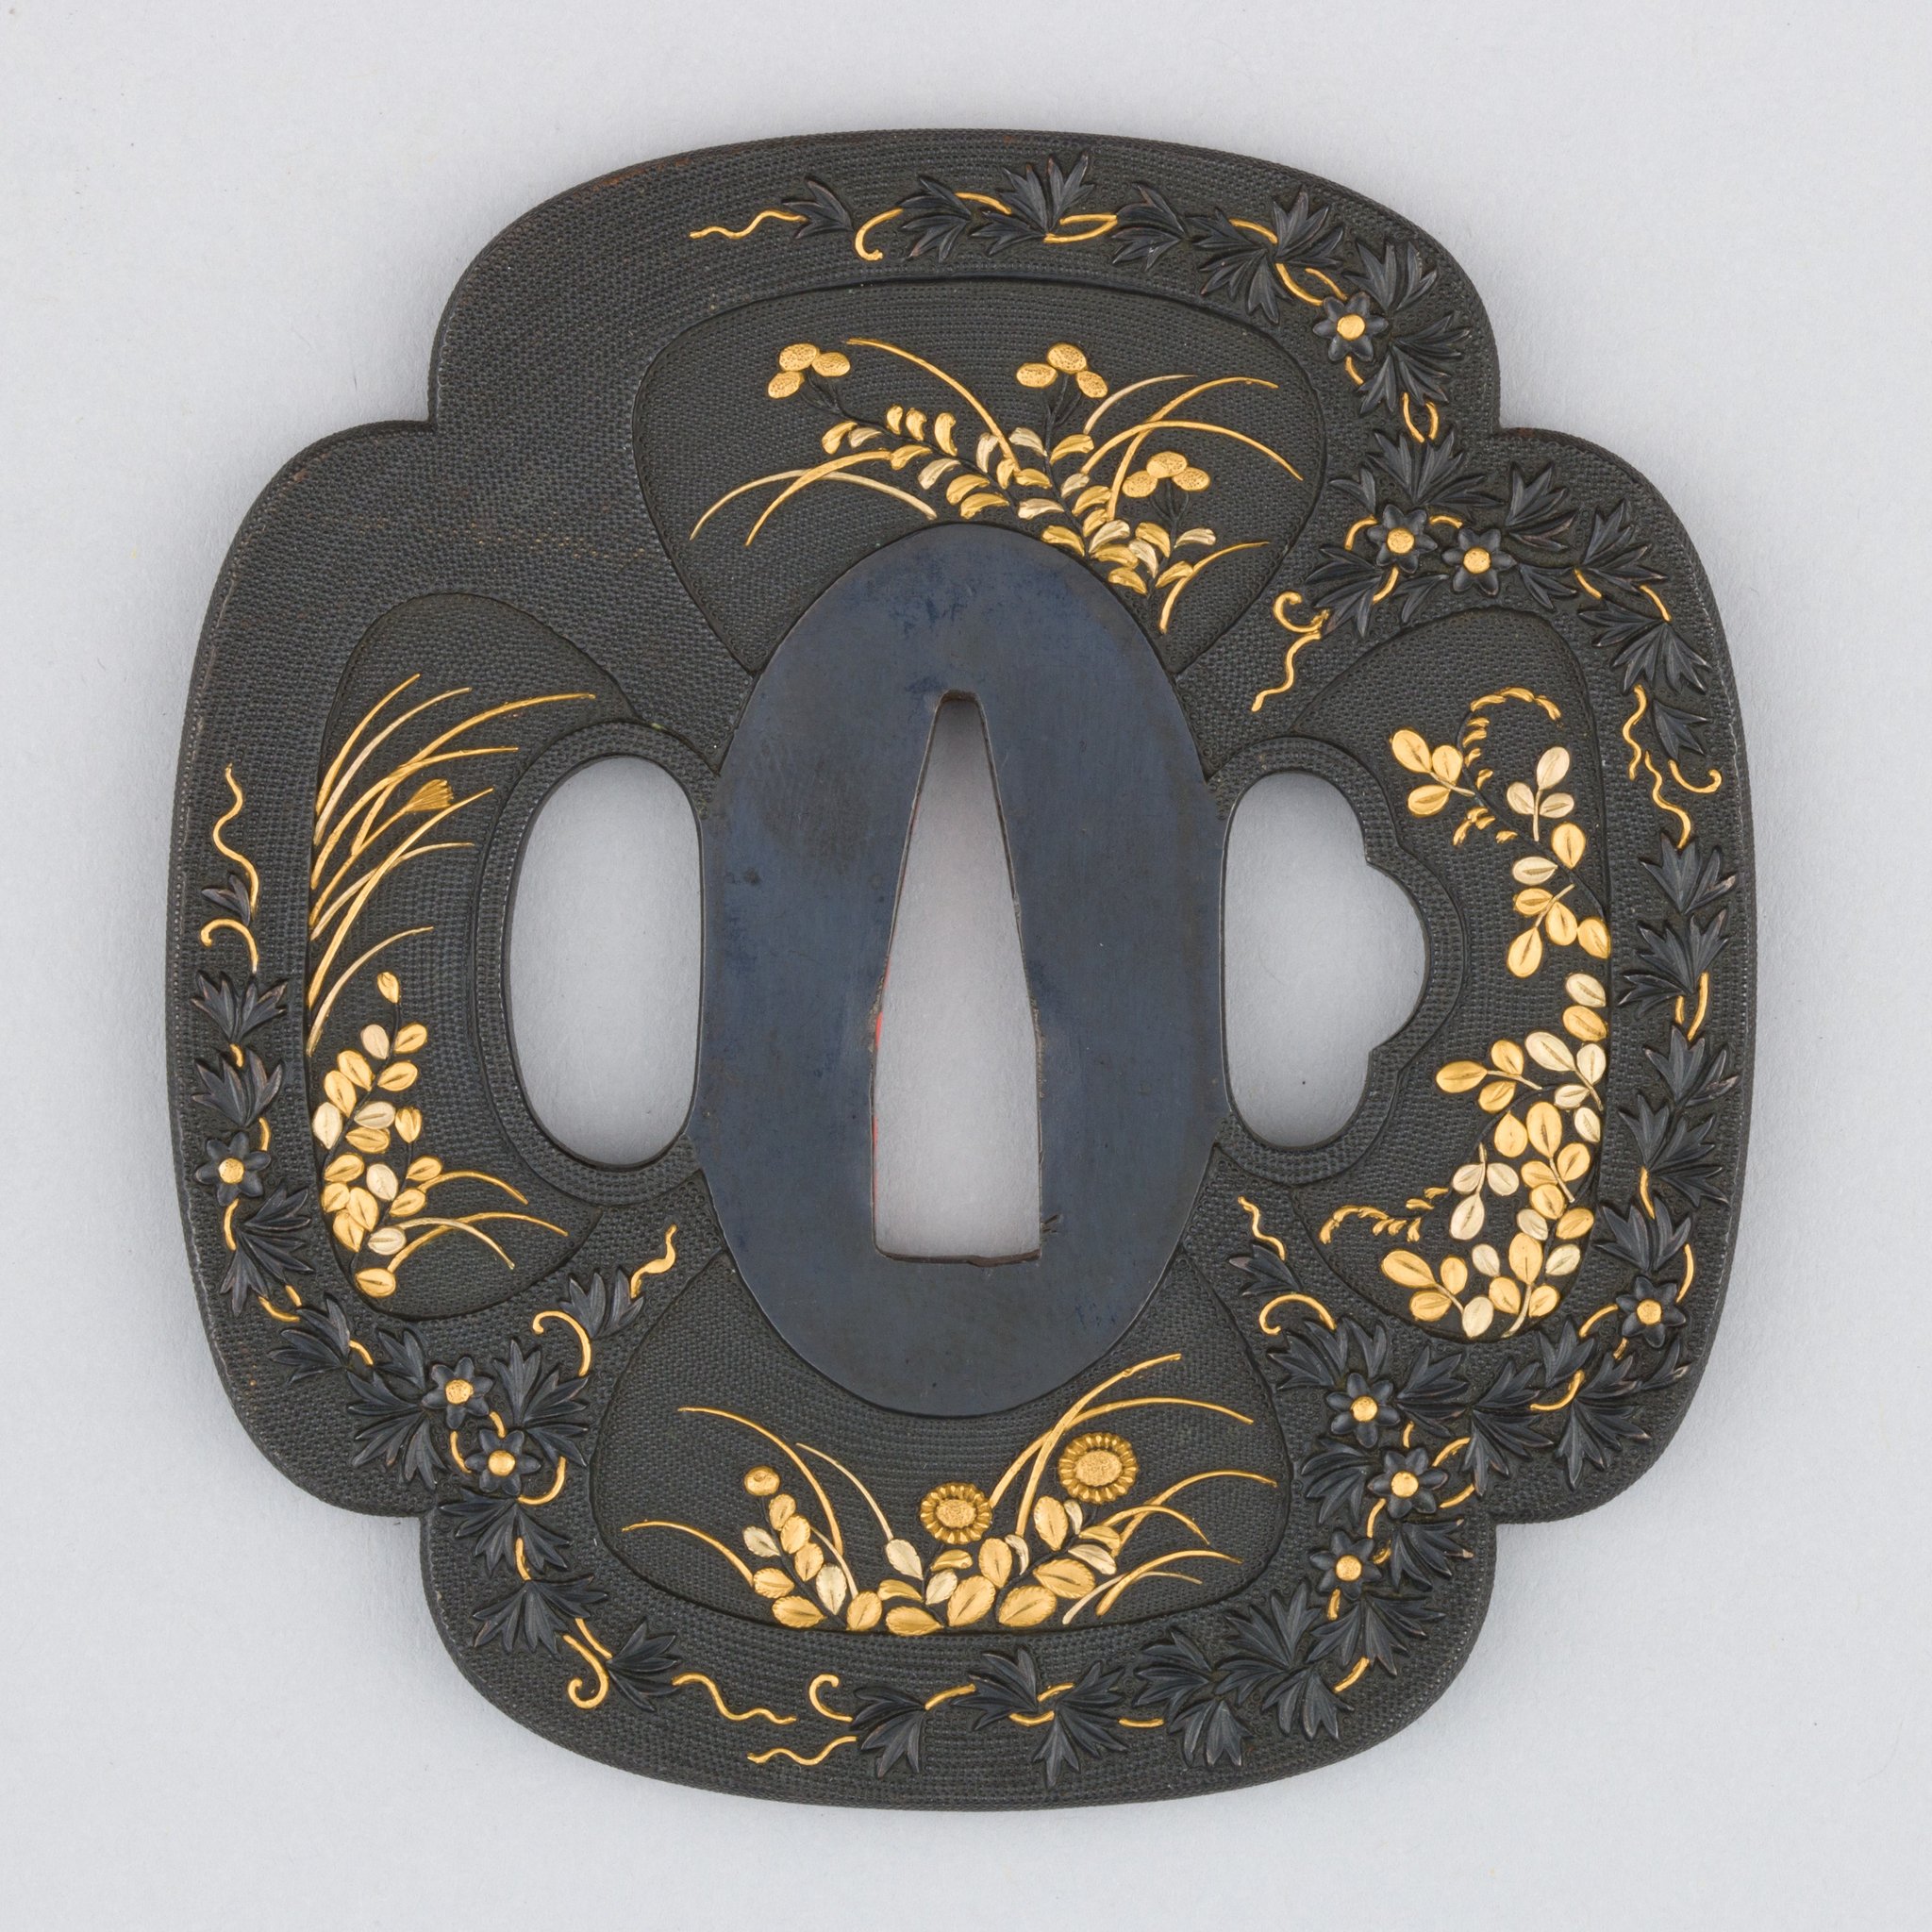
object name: sword guard tsuba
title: Sword Guard (Tsuba)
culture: japanese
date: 1701-1800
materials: copper, gold alloy, gold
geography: japan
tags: flowers